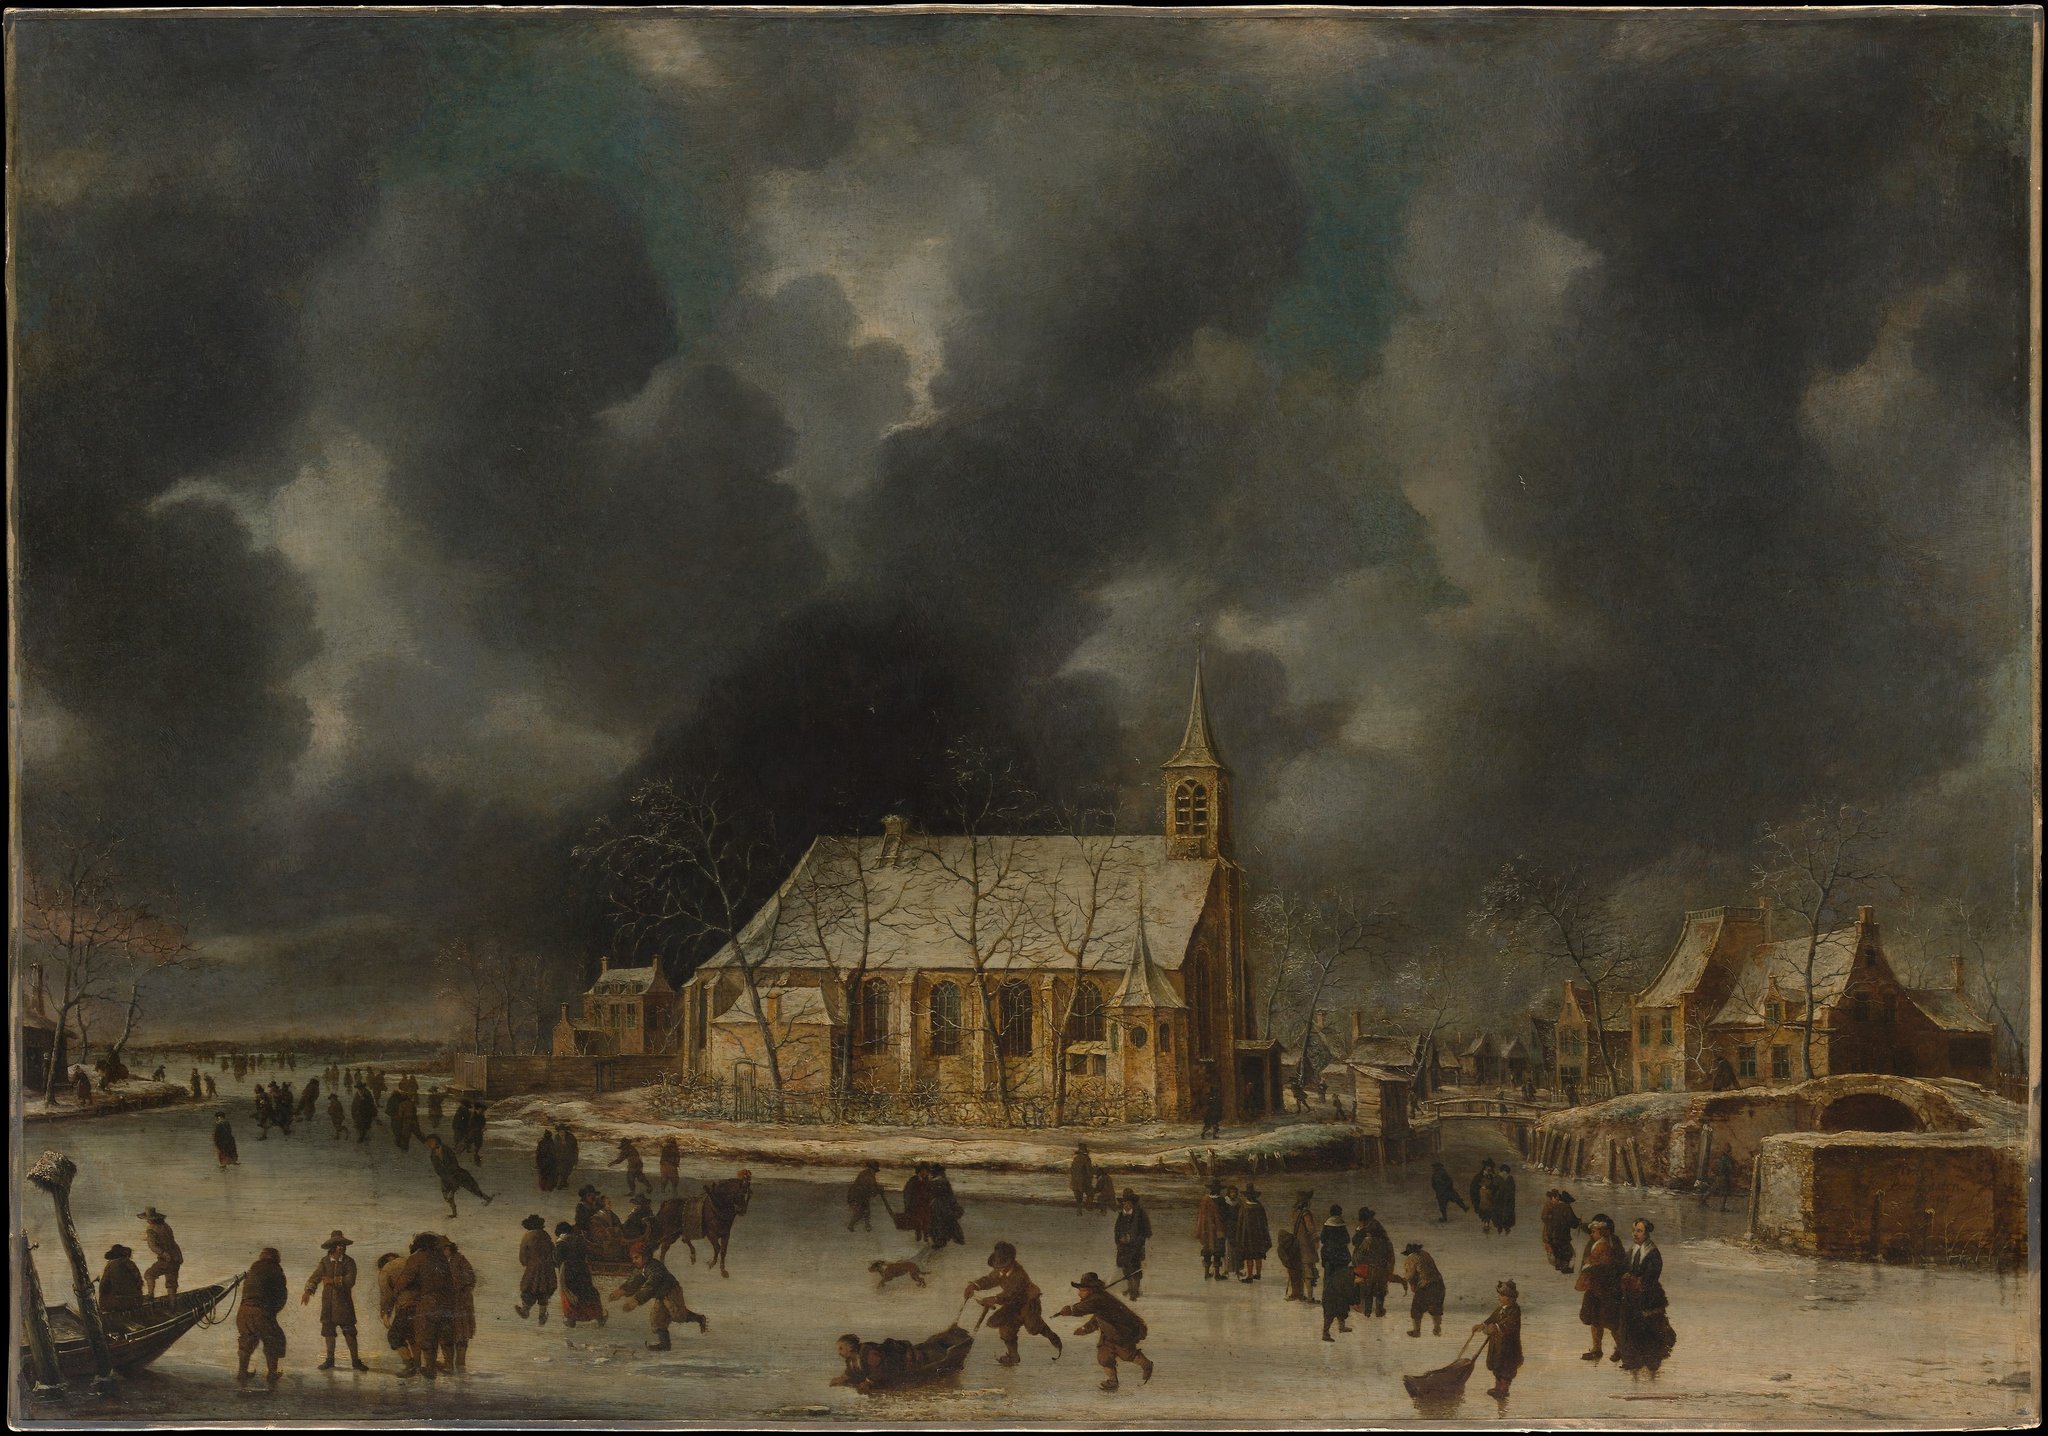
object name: painting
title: Skating at Sloten, near Amsterdam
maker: johannes abrahamsz beerstraten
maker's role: artist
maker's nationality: dutch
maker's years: 1622-1666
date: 1642-1666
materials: canvas, oil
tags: churches,men,women,skating,winter